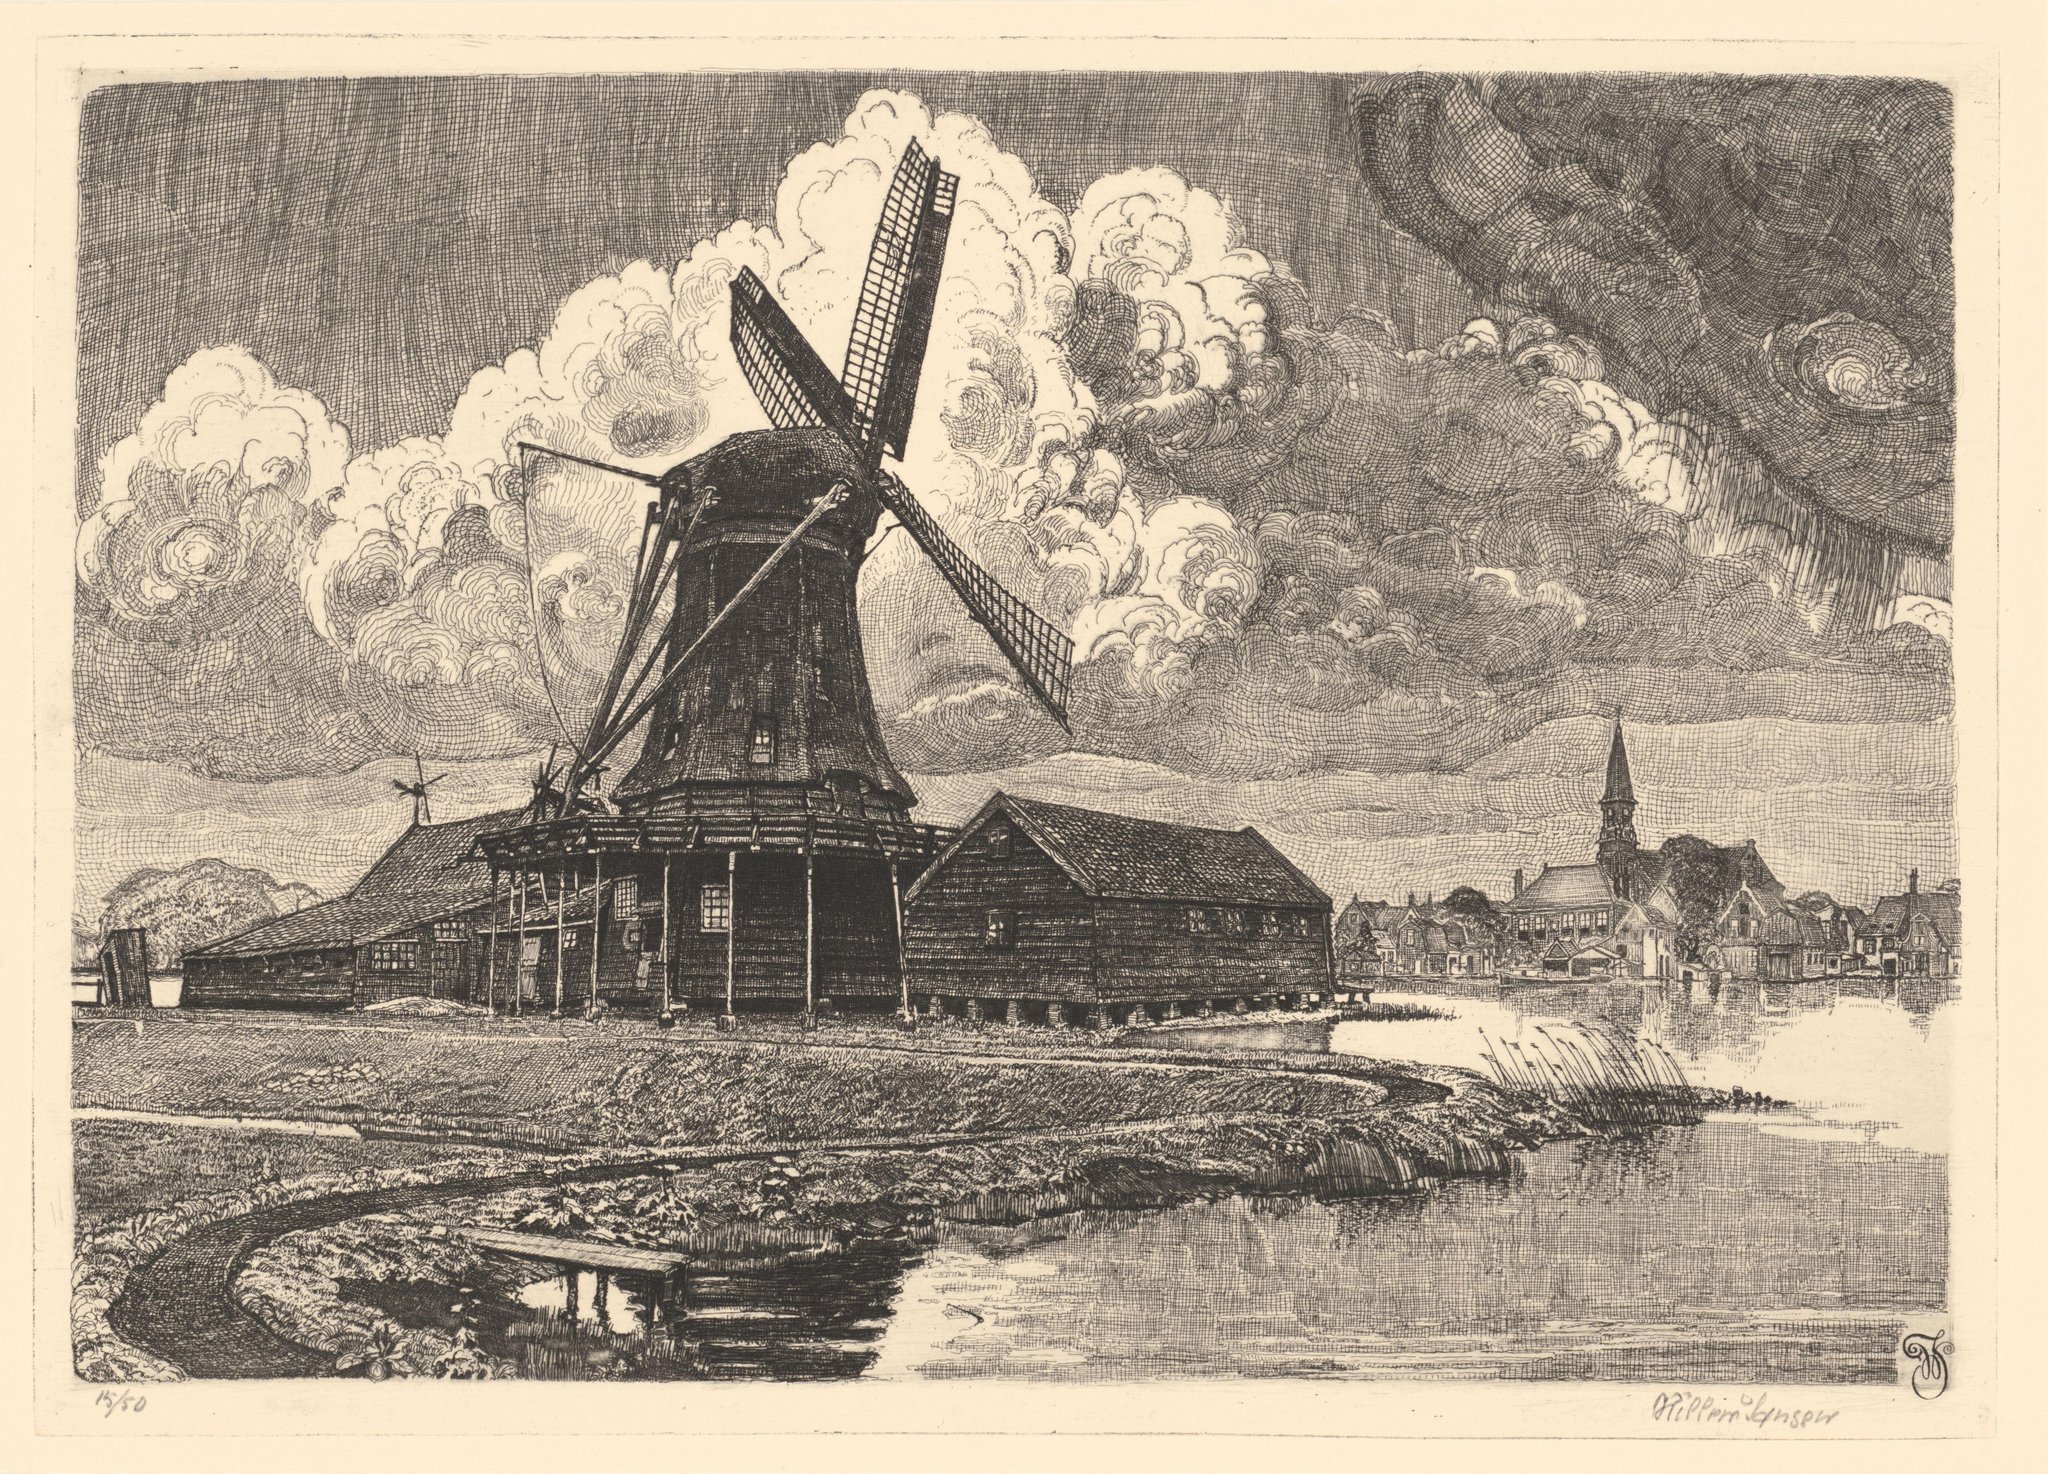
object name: print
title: Molen de Bonte Hen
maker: willem jansen (graveur)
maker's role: print maker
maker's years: 1892-1969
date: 1902-1931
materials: paper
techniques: etching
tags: windmill in landscape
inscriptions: collector's mark: Lugt 2228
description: De molen staat aan de waterkant. Op de achtergrond een dorp met een kerktoren.